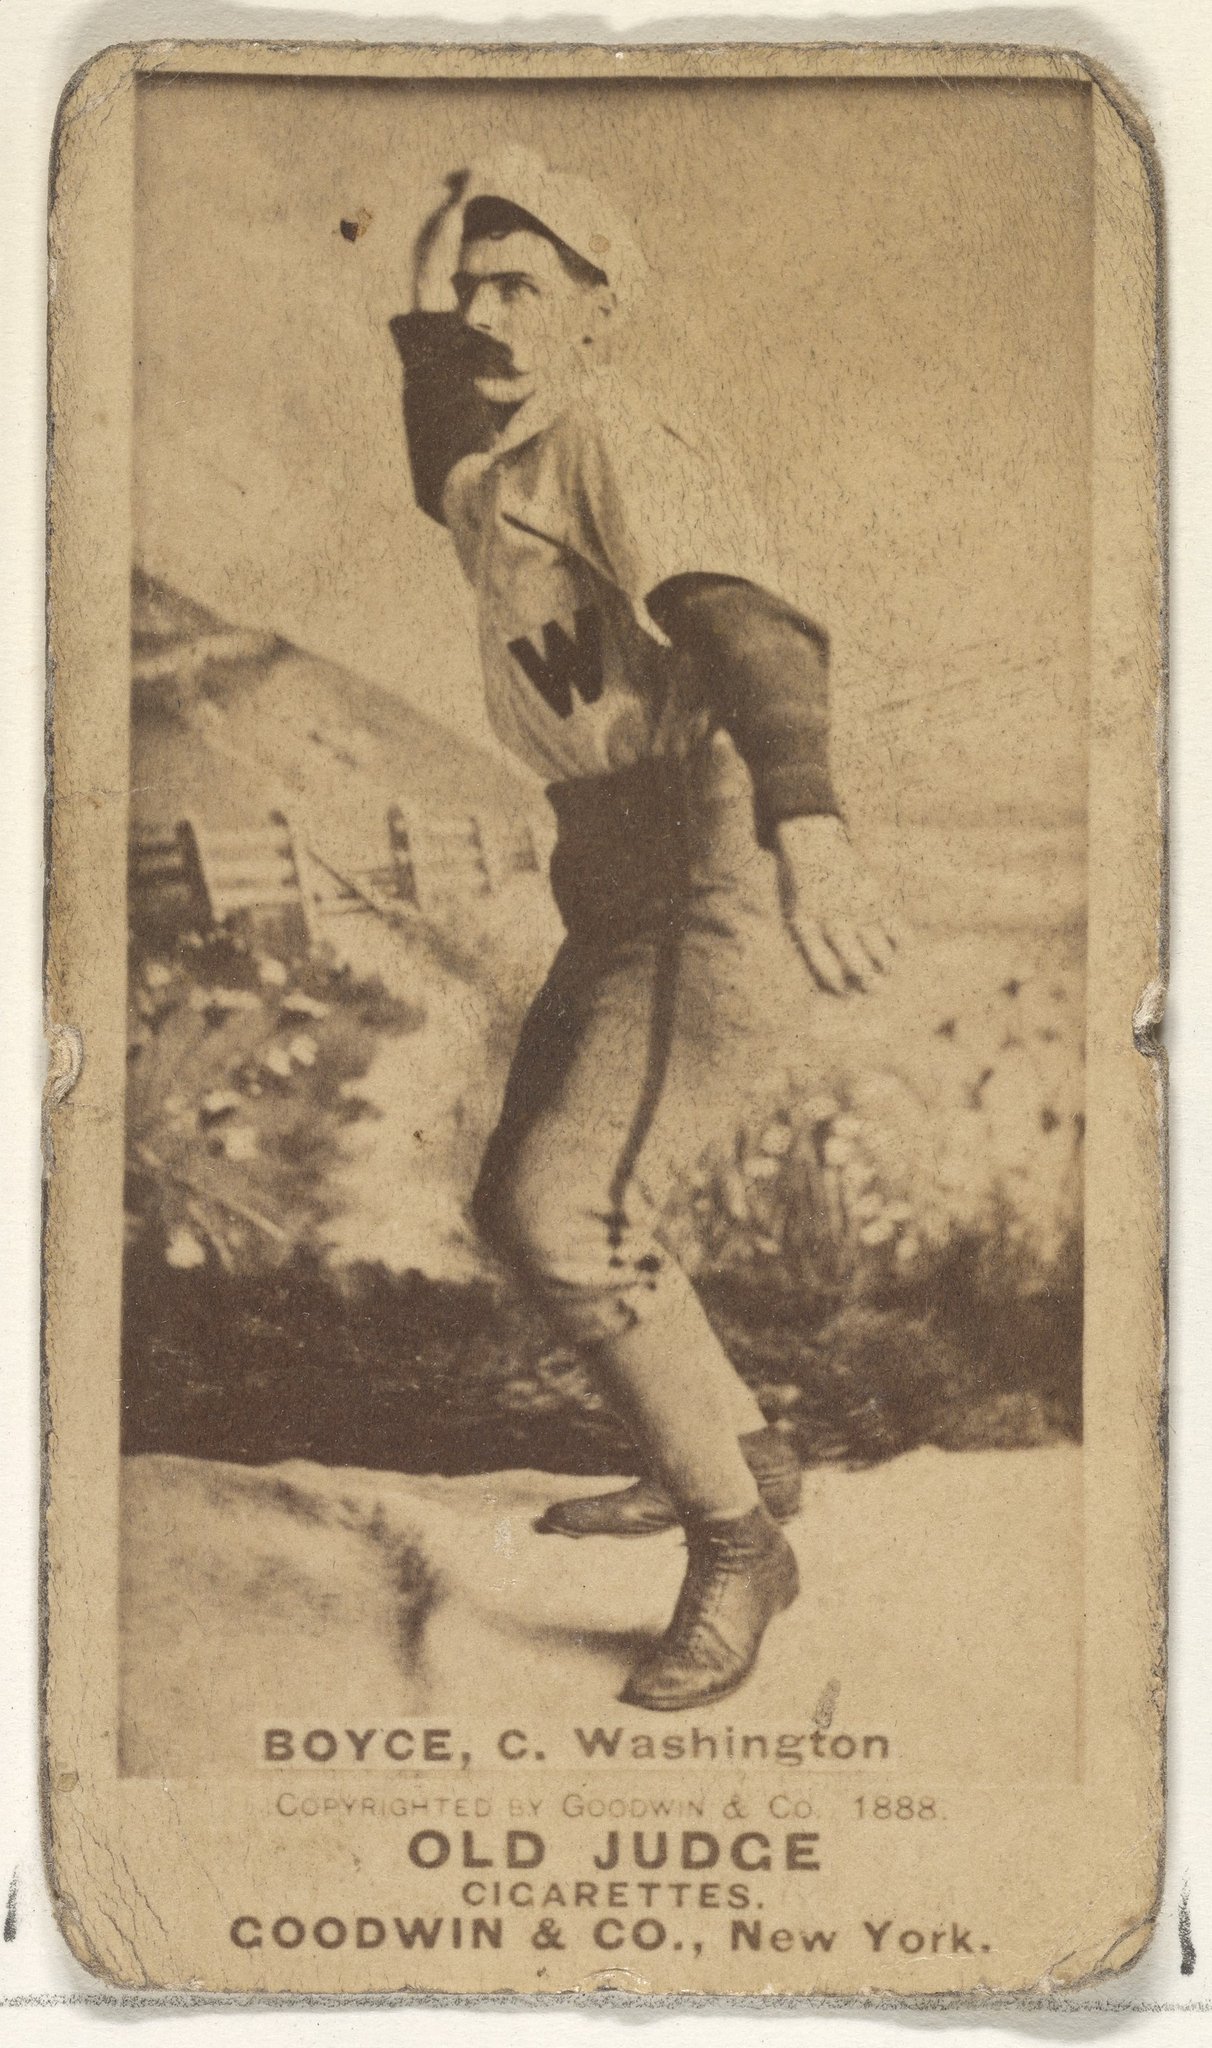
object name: baseball card, photograph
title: Boyce, Catcher, Washington, from the Old Judge series (N172) for Old Judge Cigarettes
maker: goodwin & company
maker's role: publisher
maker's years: 1850-1950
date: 1888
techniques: albumen silver print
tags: men,portraits,baseball,athletes